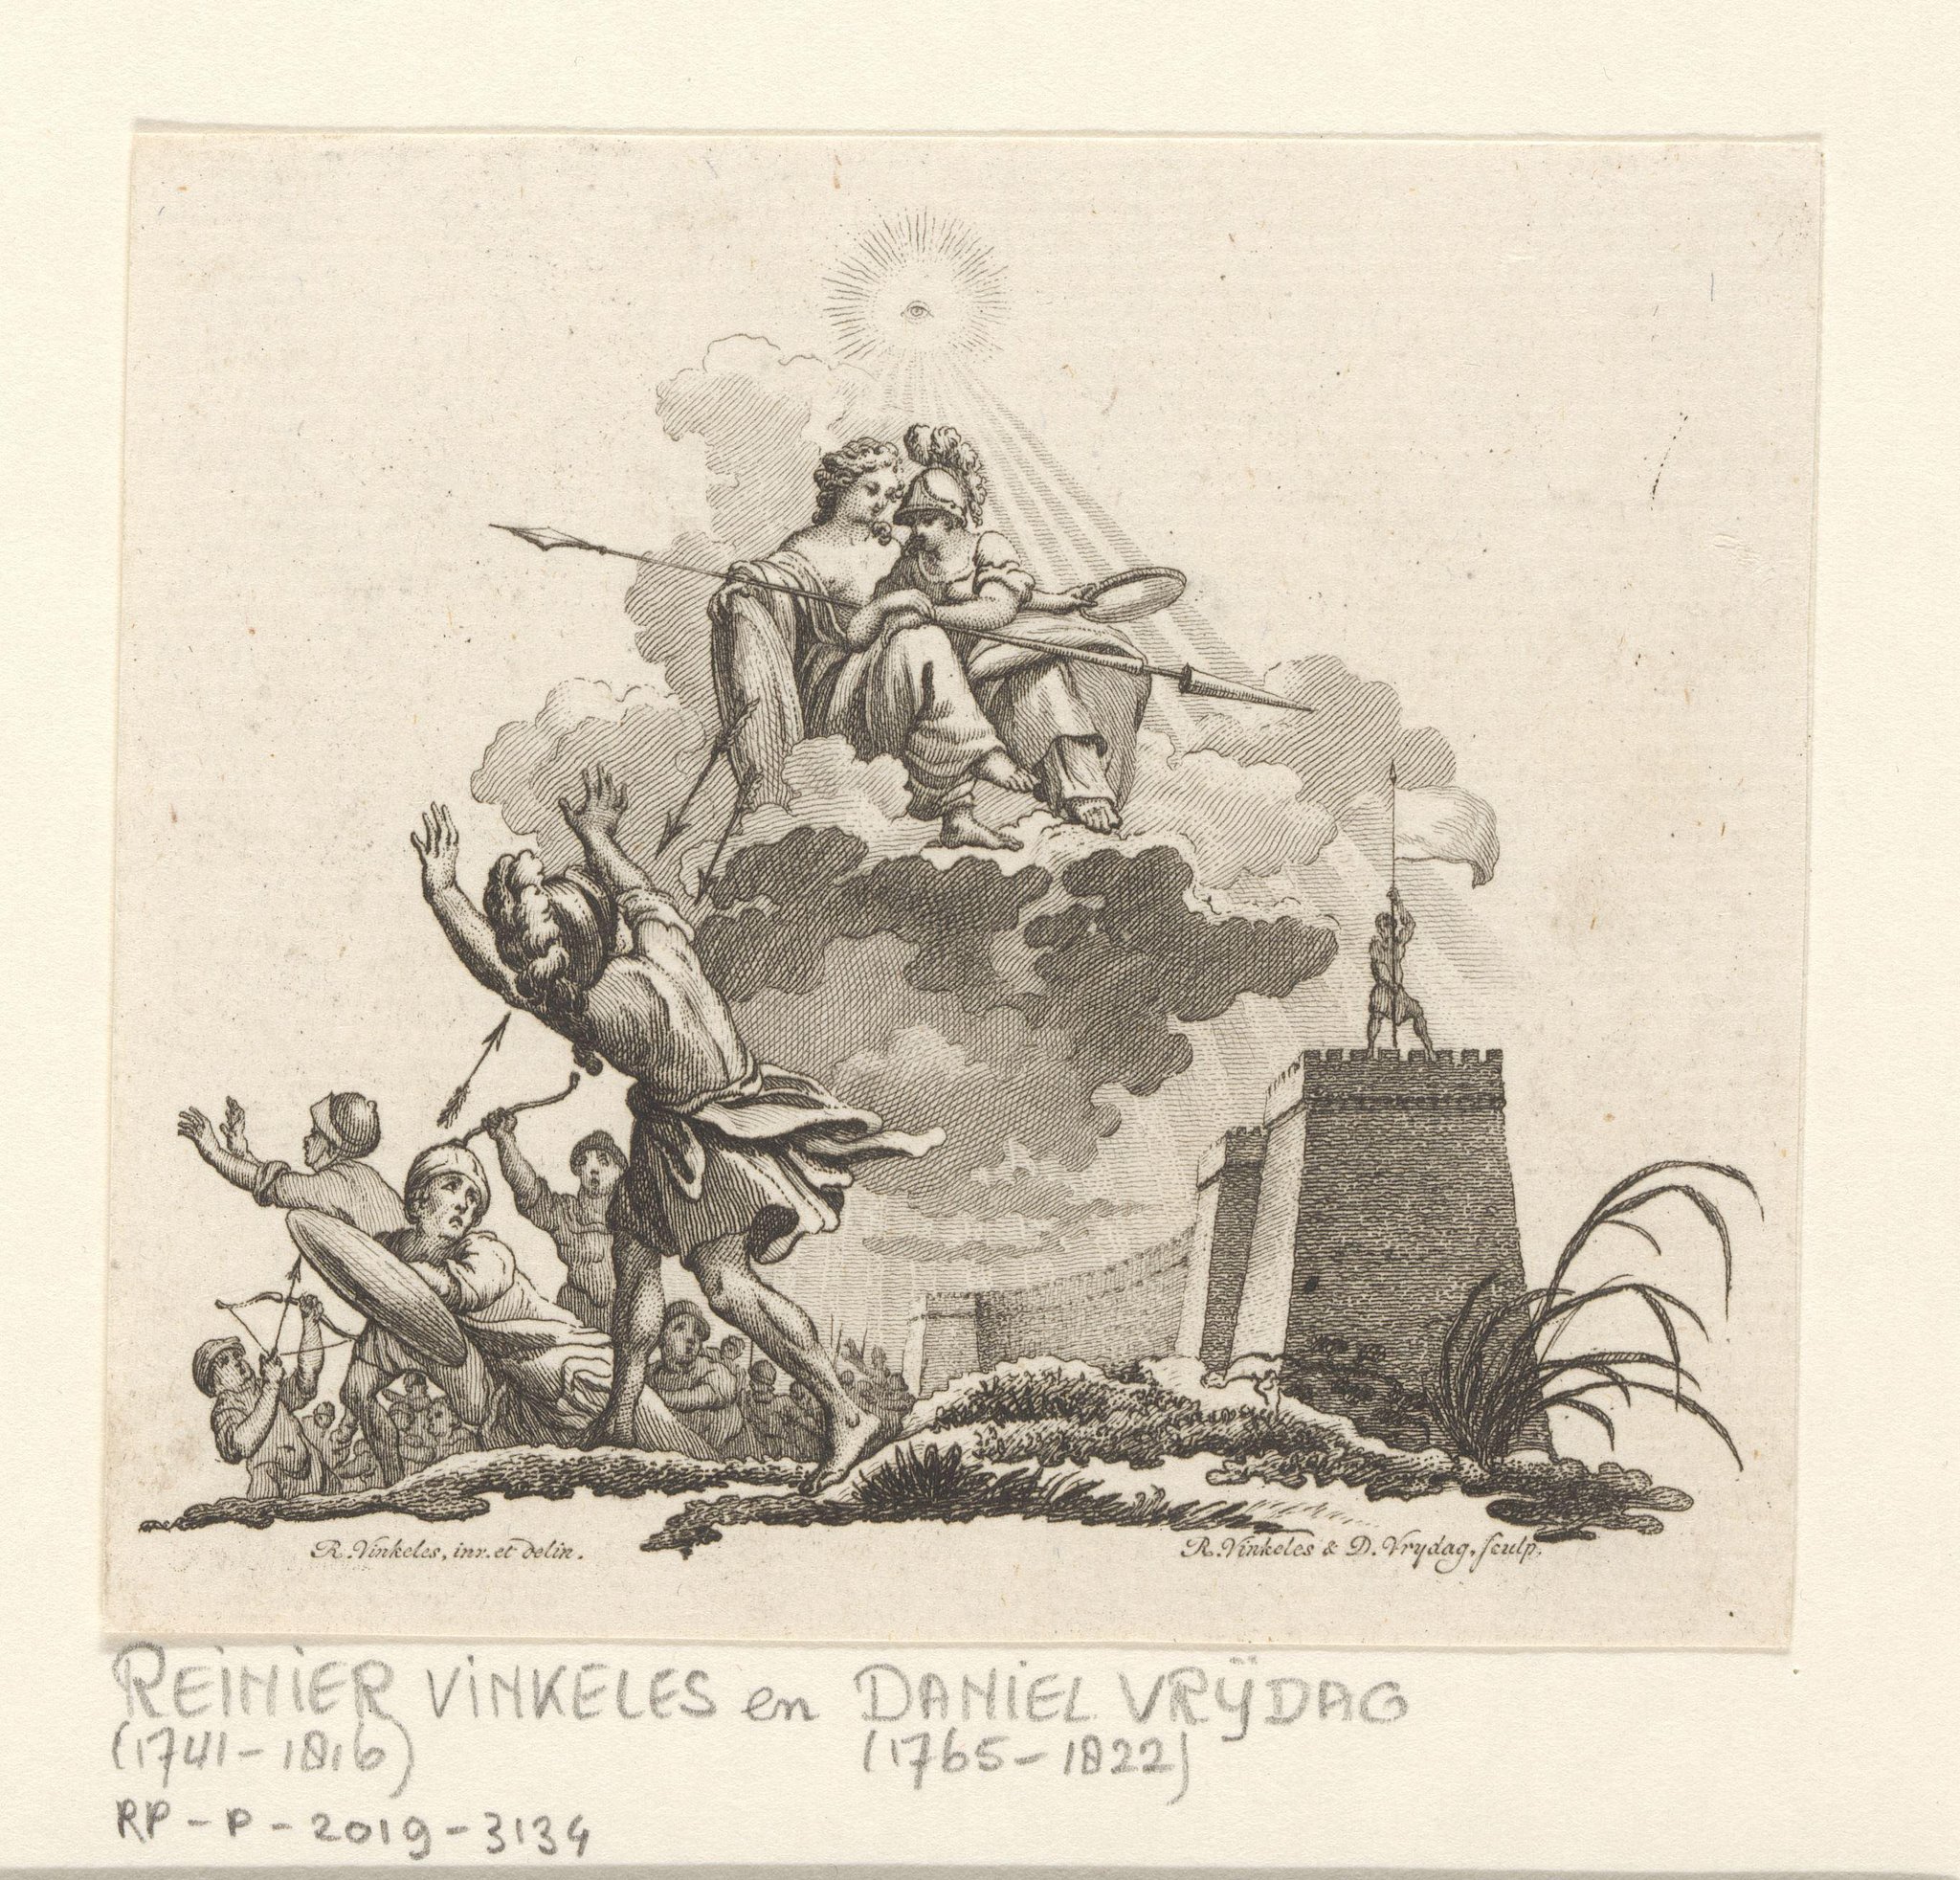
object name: vignette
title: Vignet met Minerva en soldaten beschoten met pijlen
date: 1775-1816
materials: paper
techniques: etching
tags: (story of) minerva (pallas, athena), private soldier, illustration ~ printed matter, book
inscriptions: collector's mark: Lugt 2228